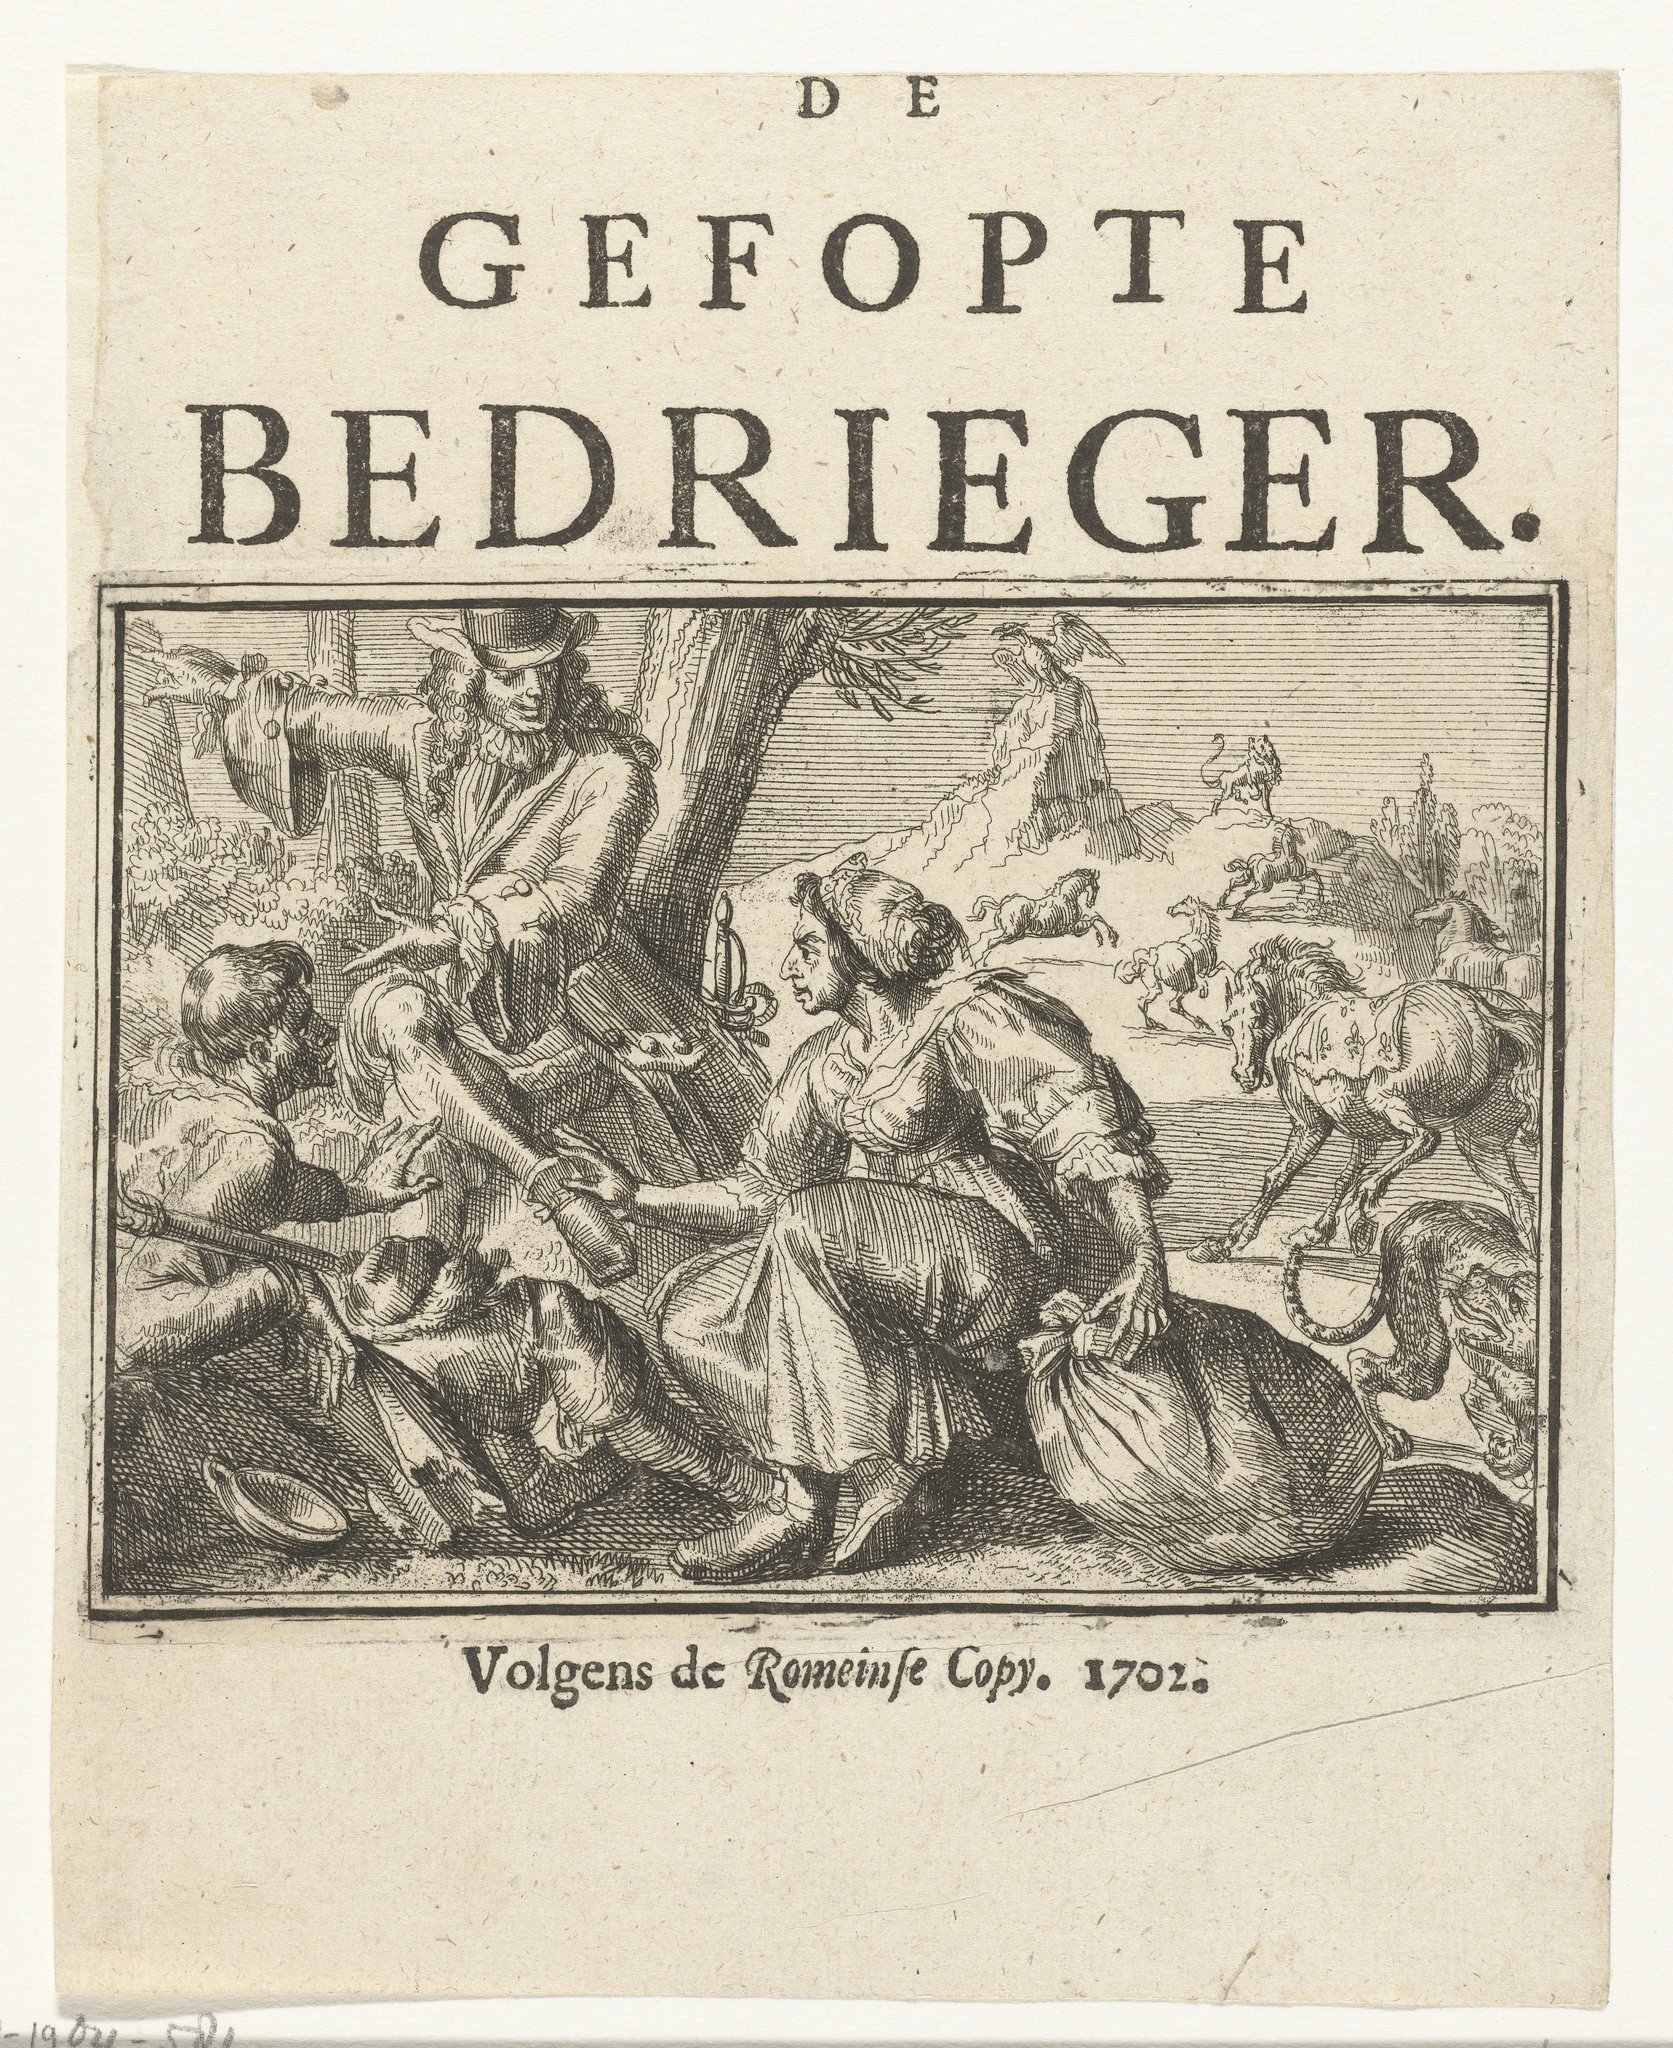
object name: print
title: Titelblad voor het pamflet: De Gefopte Bedrieger, 1702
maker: romeyn de hooghe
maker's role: draughtsman, goldsmith, painter, print maker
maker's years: 1645-1708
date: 1702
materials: paper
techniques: etching, letterpress printing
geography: northern netherlands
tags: wandering communities: romani or roma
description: Titelblad voor het pamflet: De Gefopte Bedrieger, 1702. Een zigeunerin of herderin pratend met twee mannen. Naar aanleiding van de pogingen van Frankrijk om Brunswijk om te kopen.